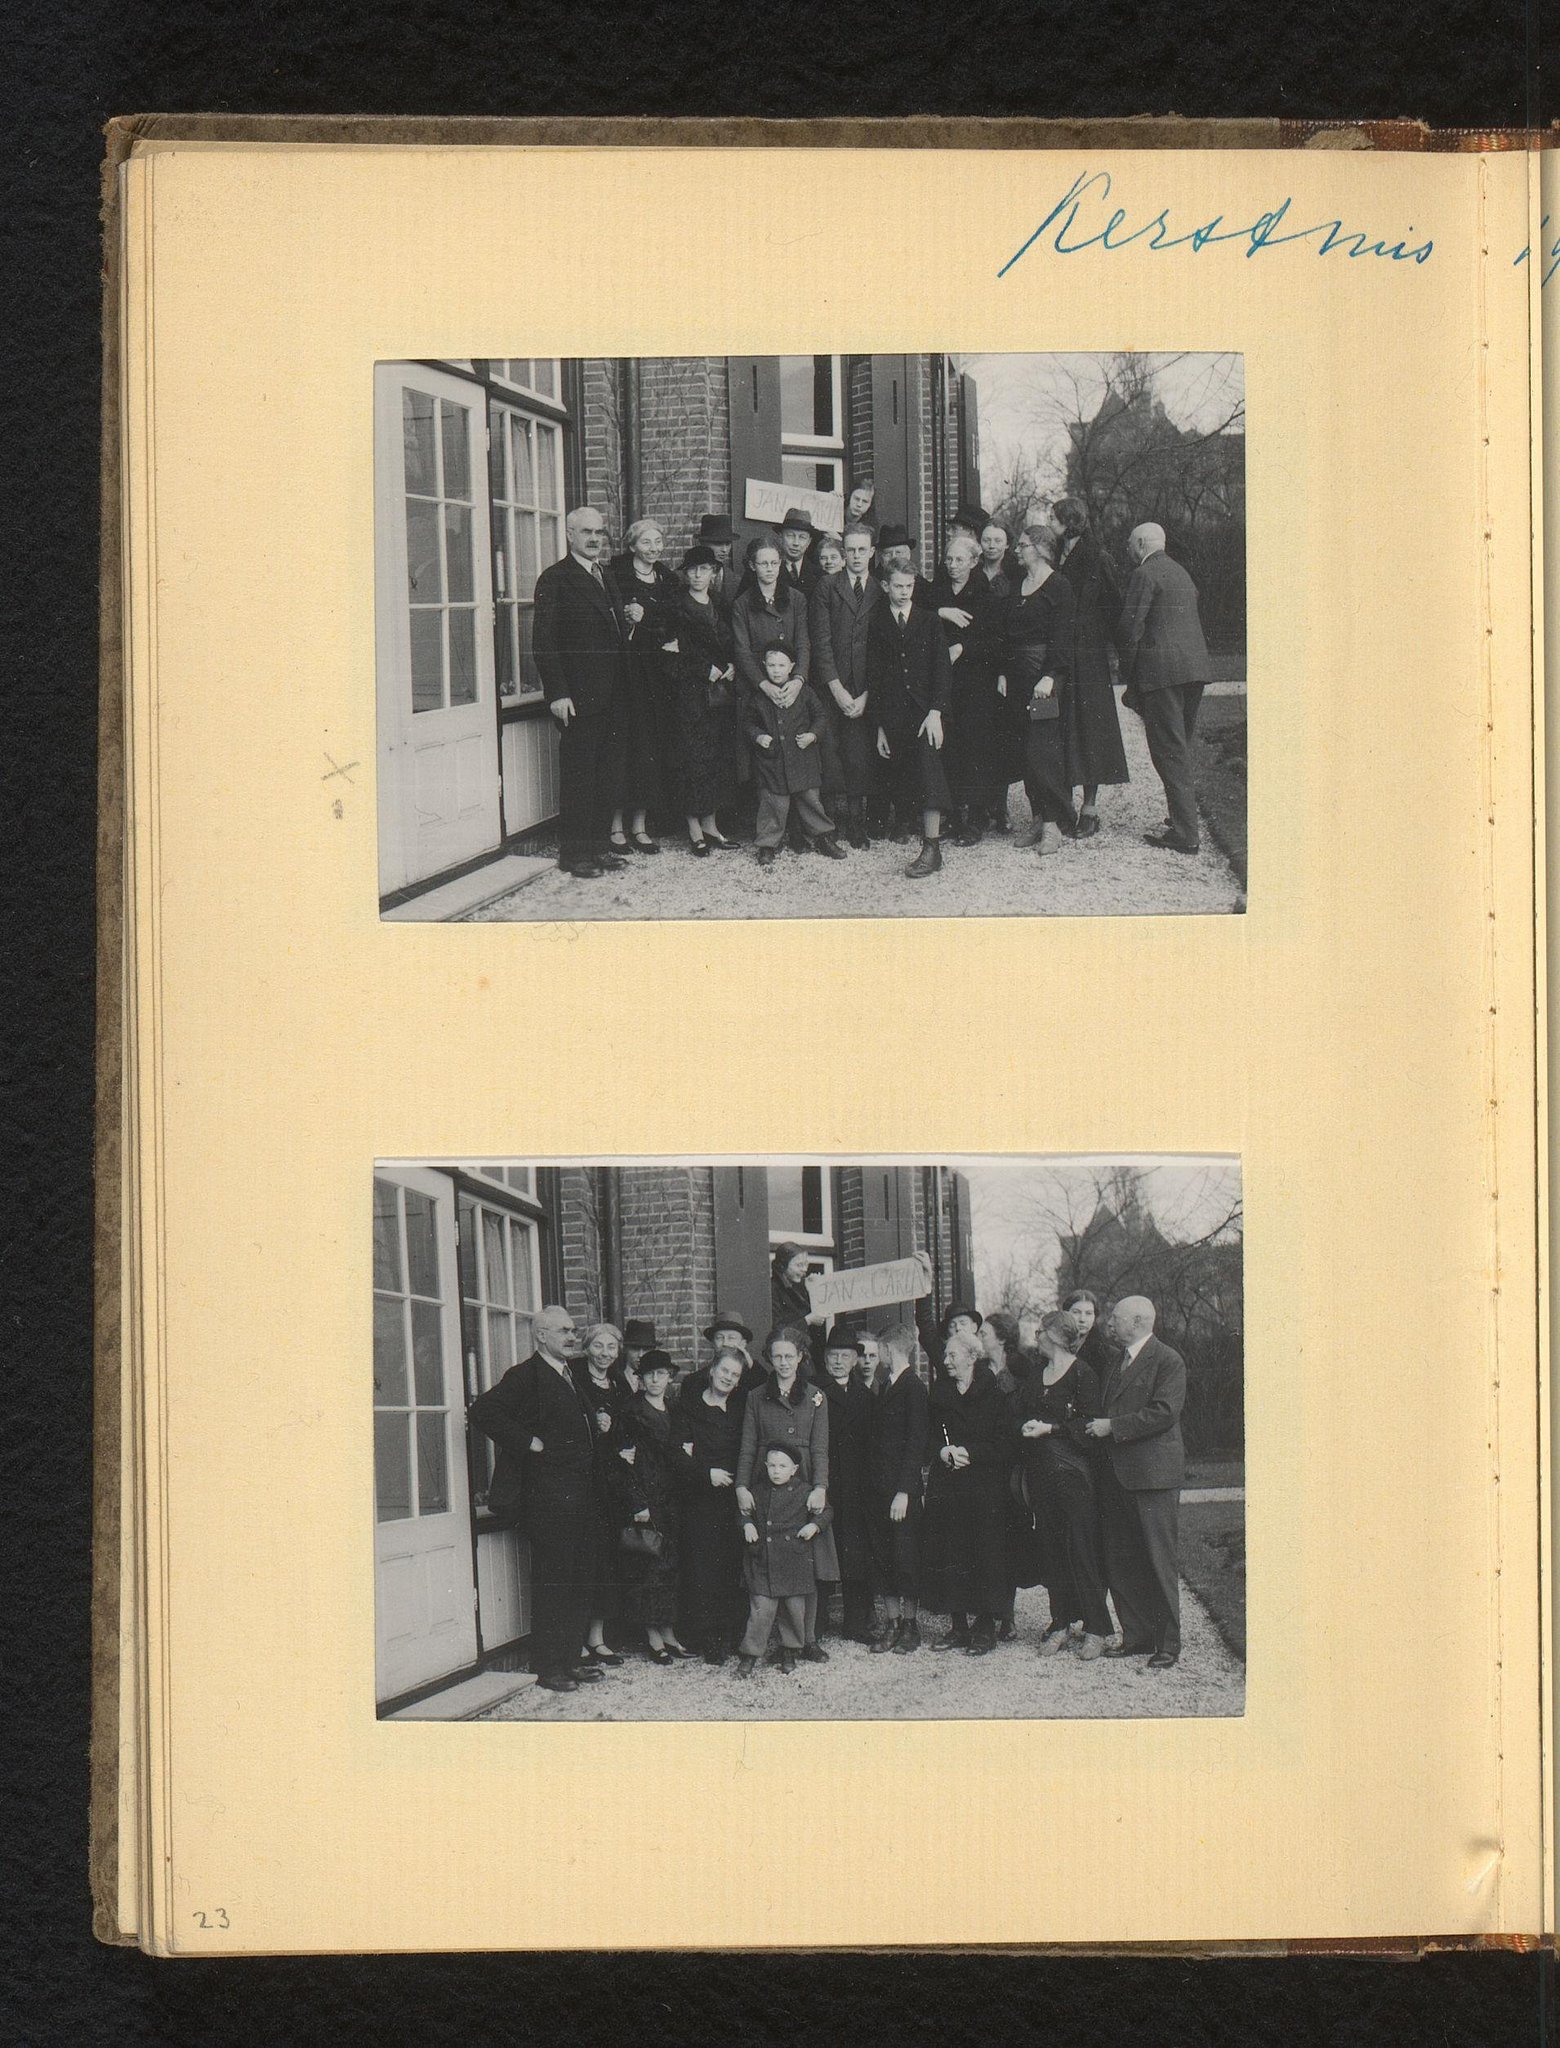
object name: album leaf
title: Kerstmis 1935 Heerlen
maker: Anonymous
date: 1912-1935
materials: paper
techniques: gelatin silver print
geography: heerlen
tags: family life, anonymous historical persons portrayed in a group, in a group-portrait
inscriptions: inscription: ‘Kerstmis 1935 Heerlen’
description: Deze foto's maken deel uit van een album.